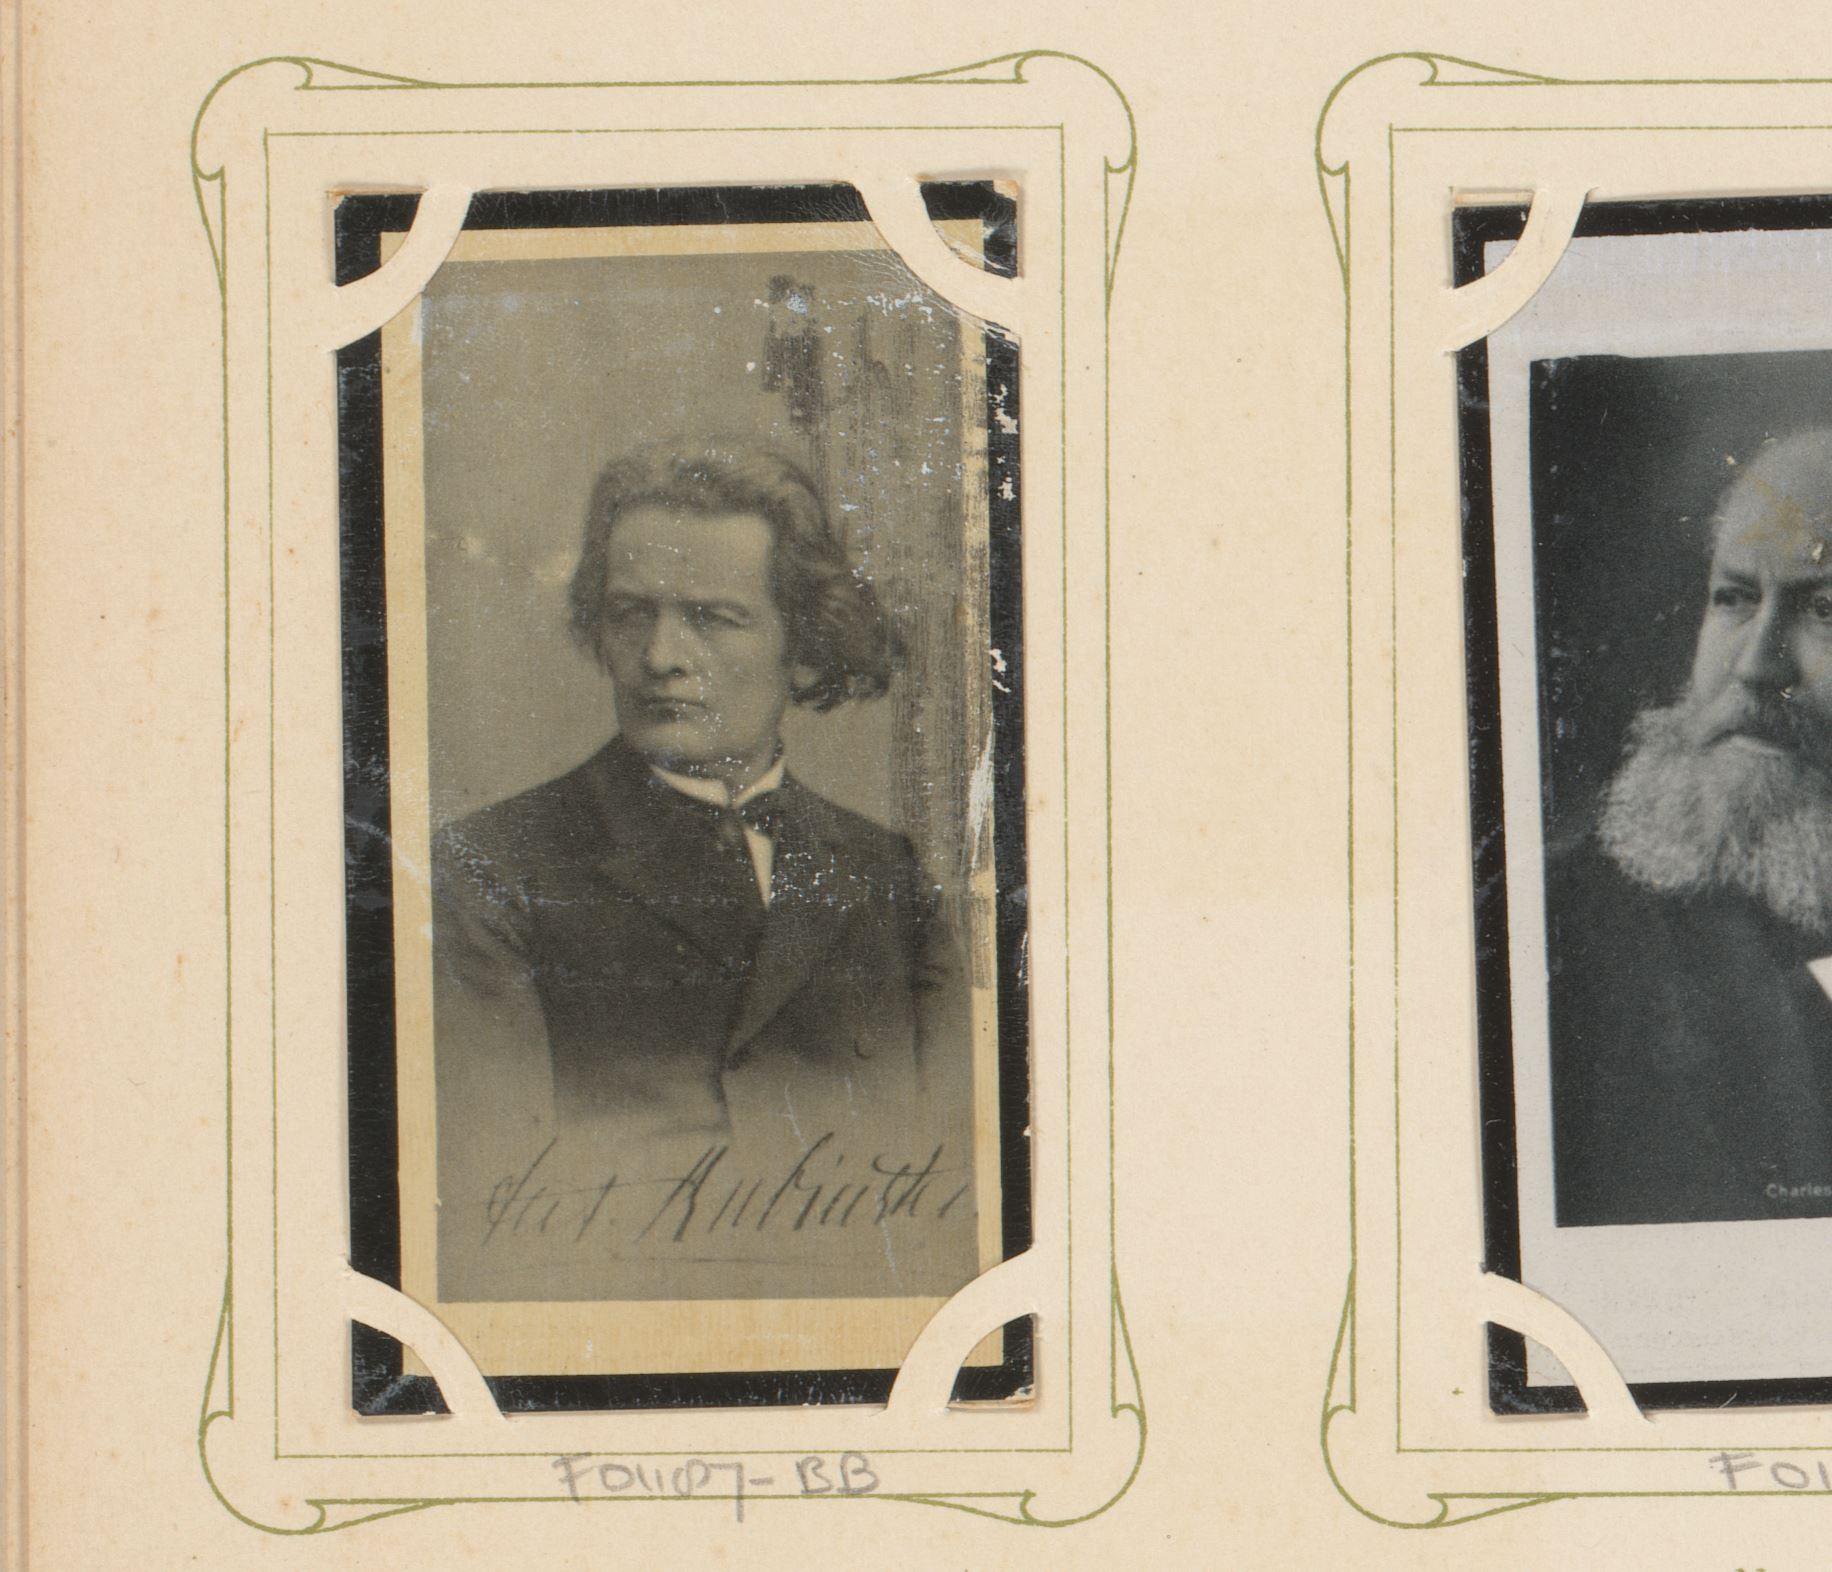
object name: photomechanical print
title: Portret van Anton Rubinstein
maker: Anonymous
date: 1905-1906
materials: paper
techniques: photograph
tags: historical persons, portrait of composer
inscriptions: inscription: ‘No. 1./ Ant. Rubinstein.’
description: Deze prent maakt deel uit van een album.